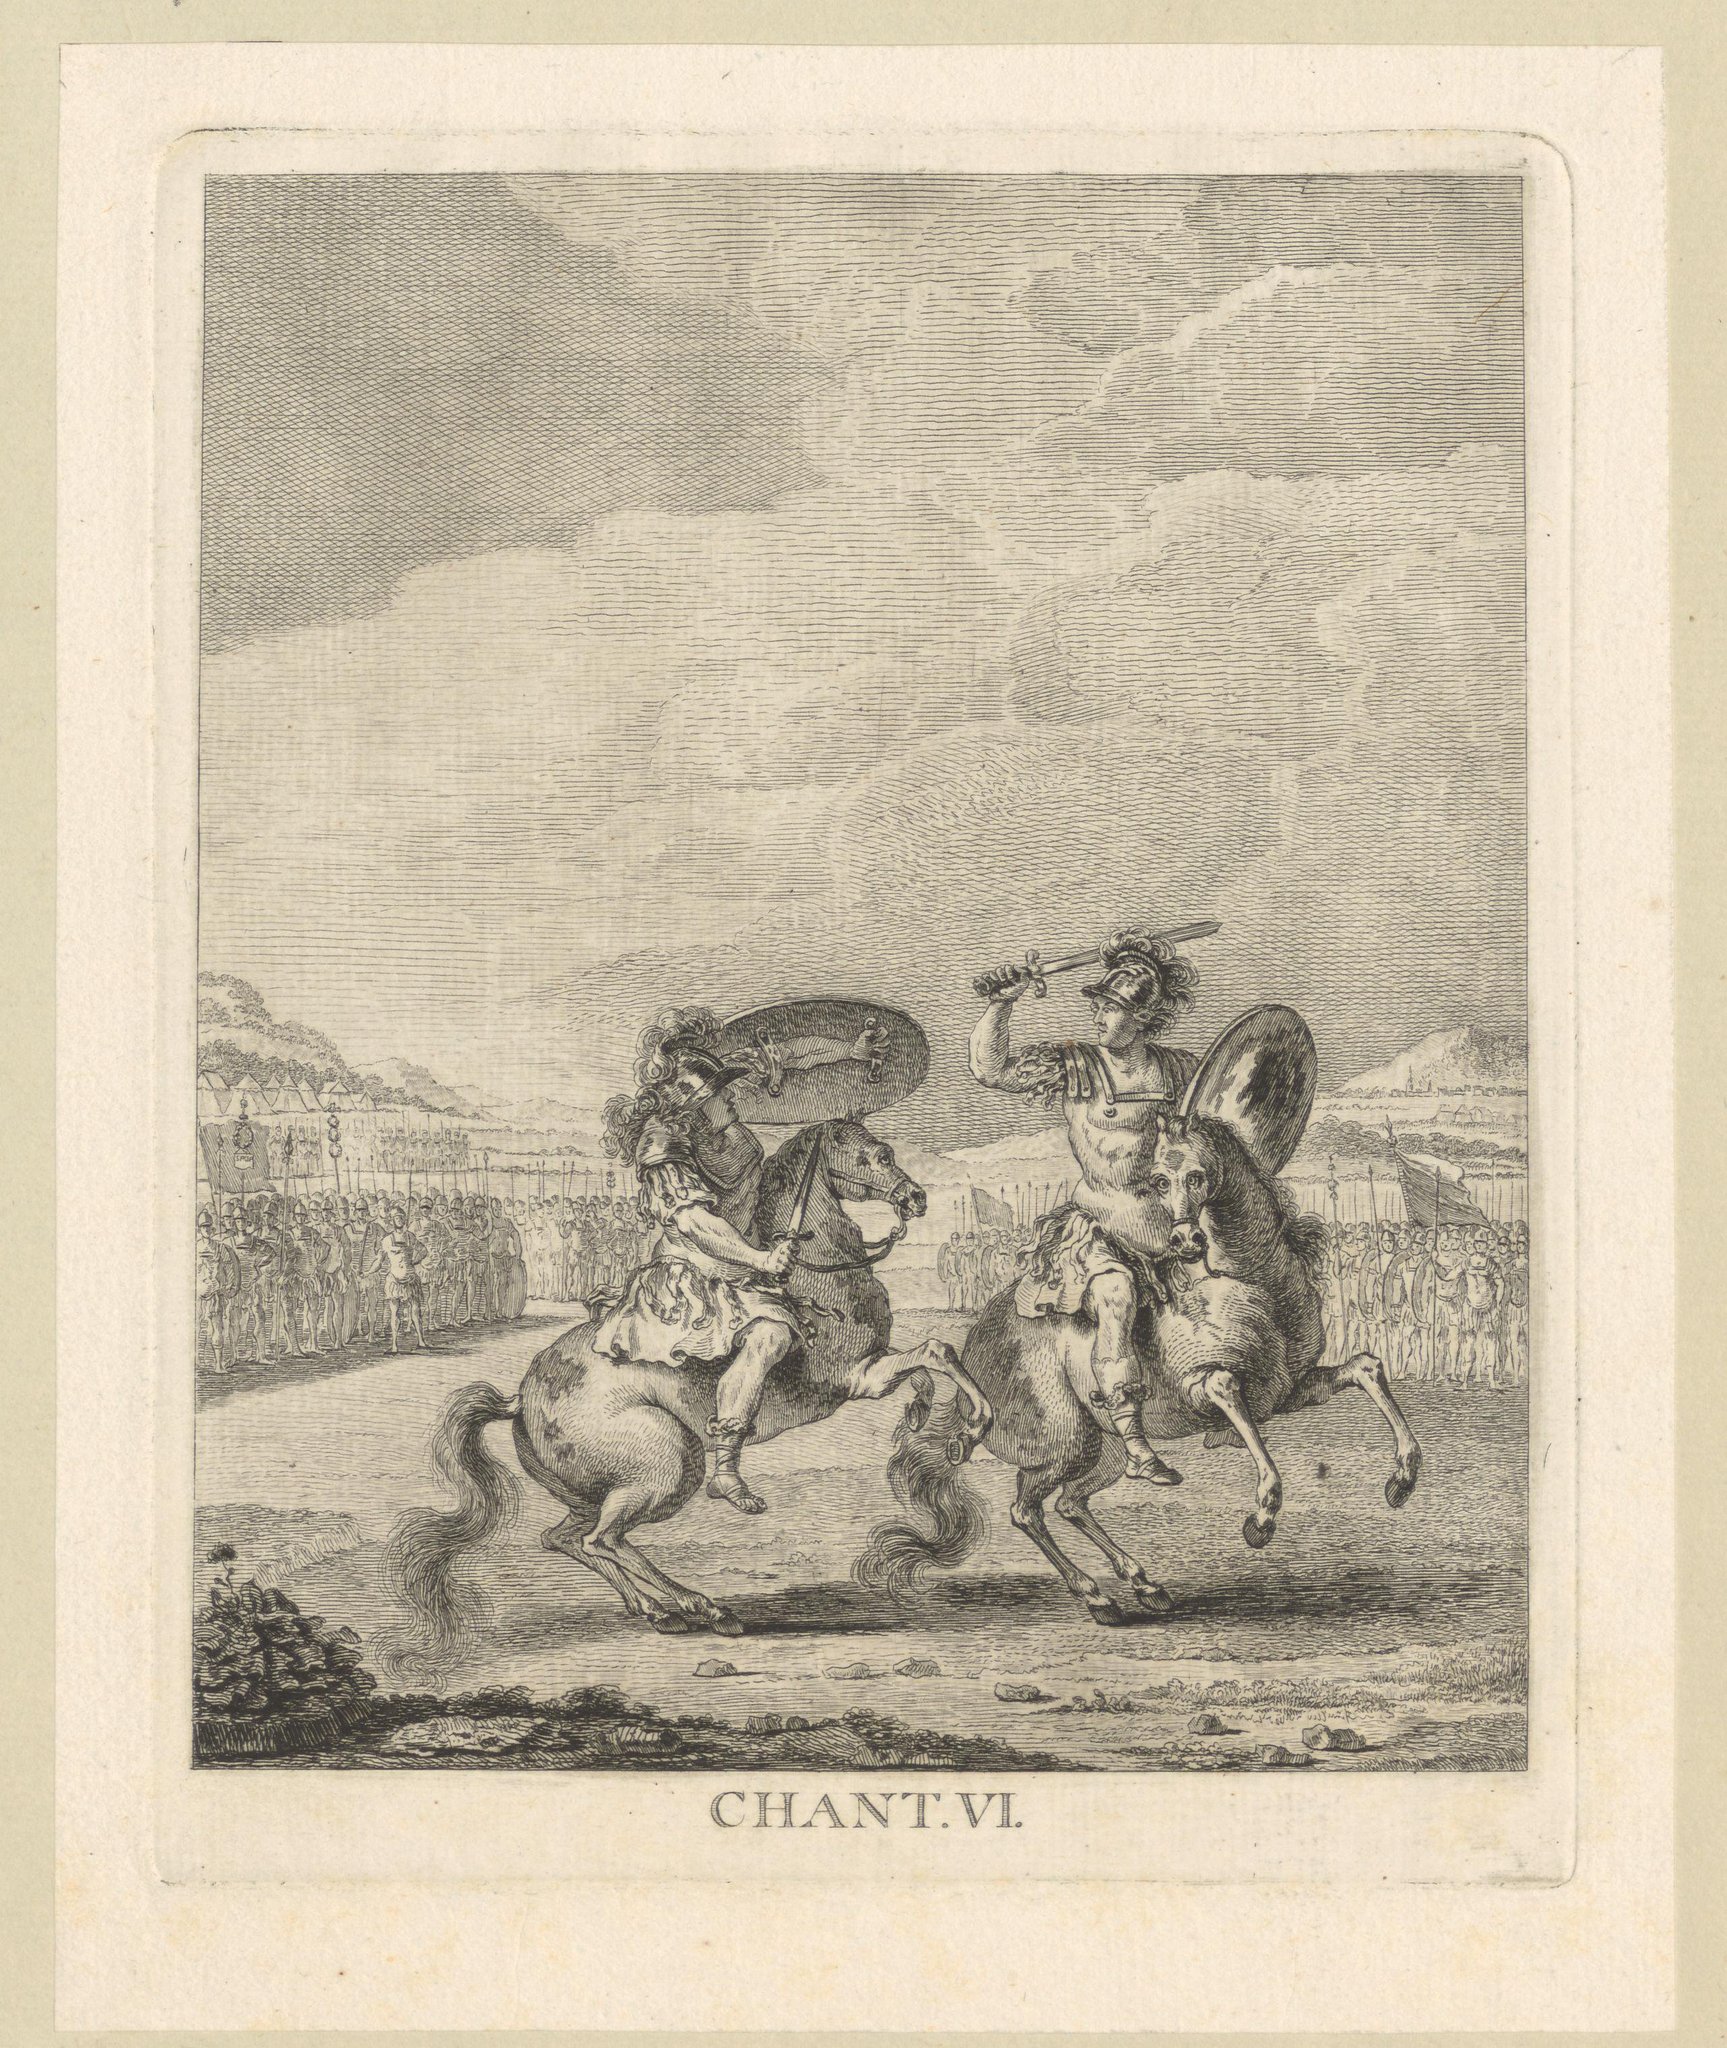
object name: print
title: Duel te paard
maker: georg friedrich schmidt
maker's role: draughtsman, print maker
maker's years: 1712-1775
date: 1774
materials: paper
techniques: etching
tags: duel in place of battle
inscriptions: collector's mark: Lugt 240